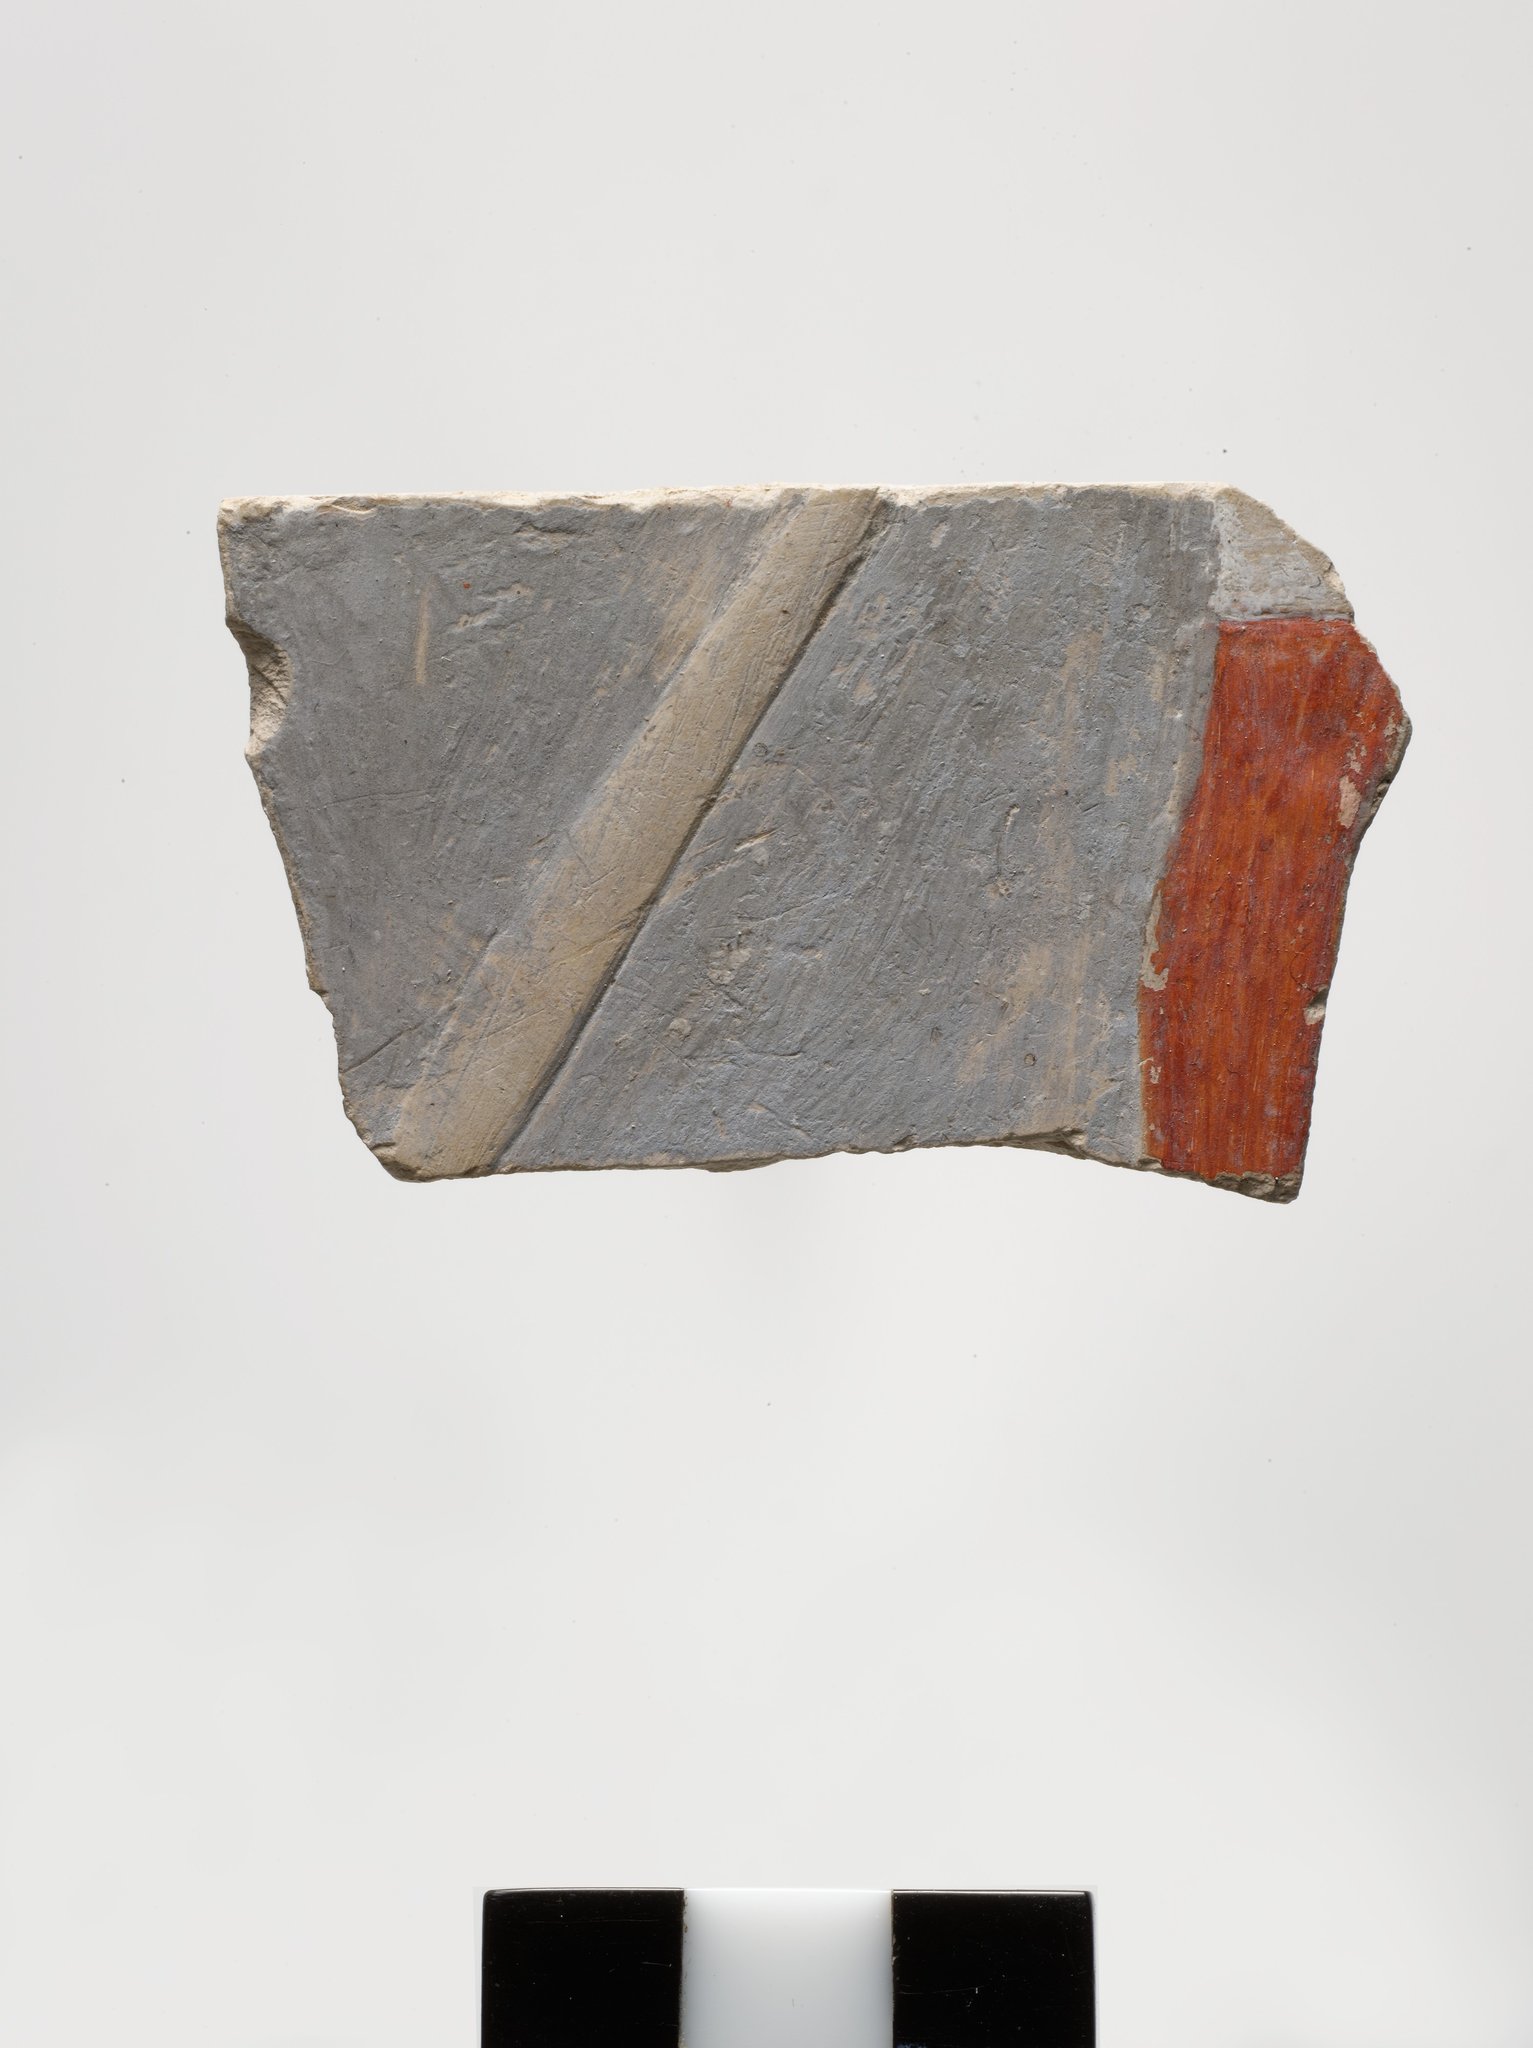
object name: relief fragment, tomb of meketre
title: Relief fragment from the tomb of Meketre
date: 1981-1975 BCE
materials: limestone, paint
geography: egypt